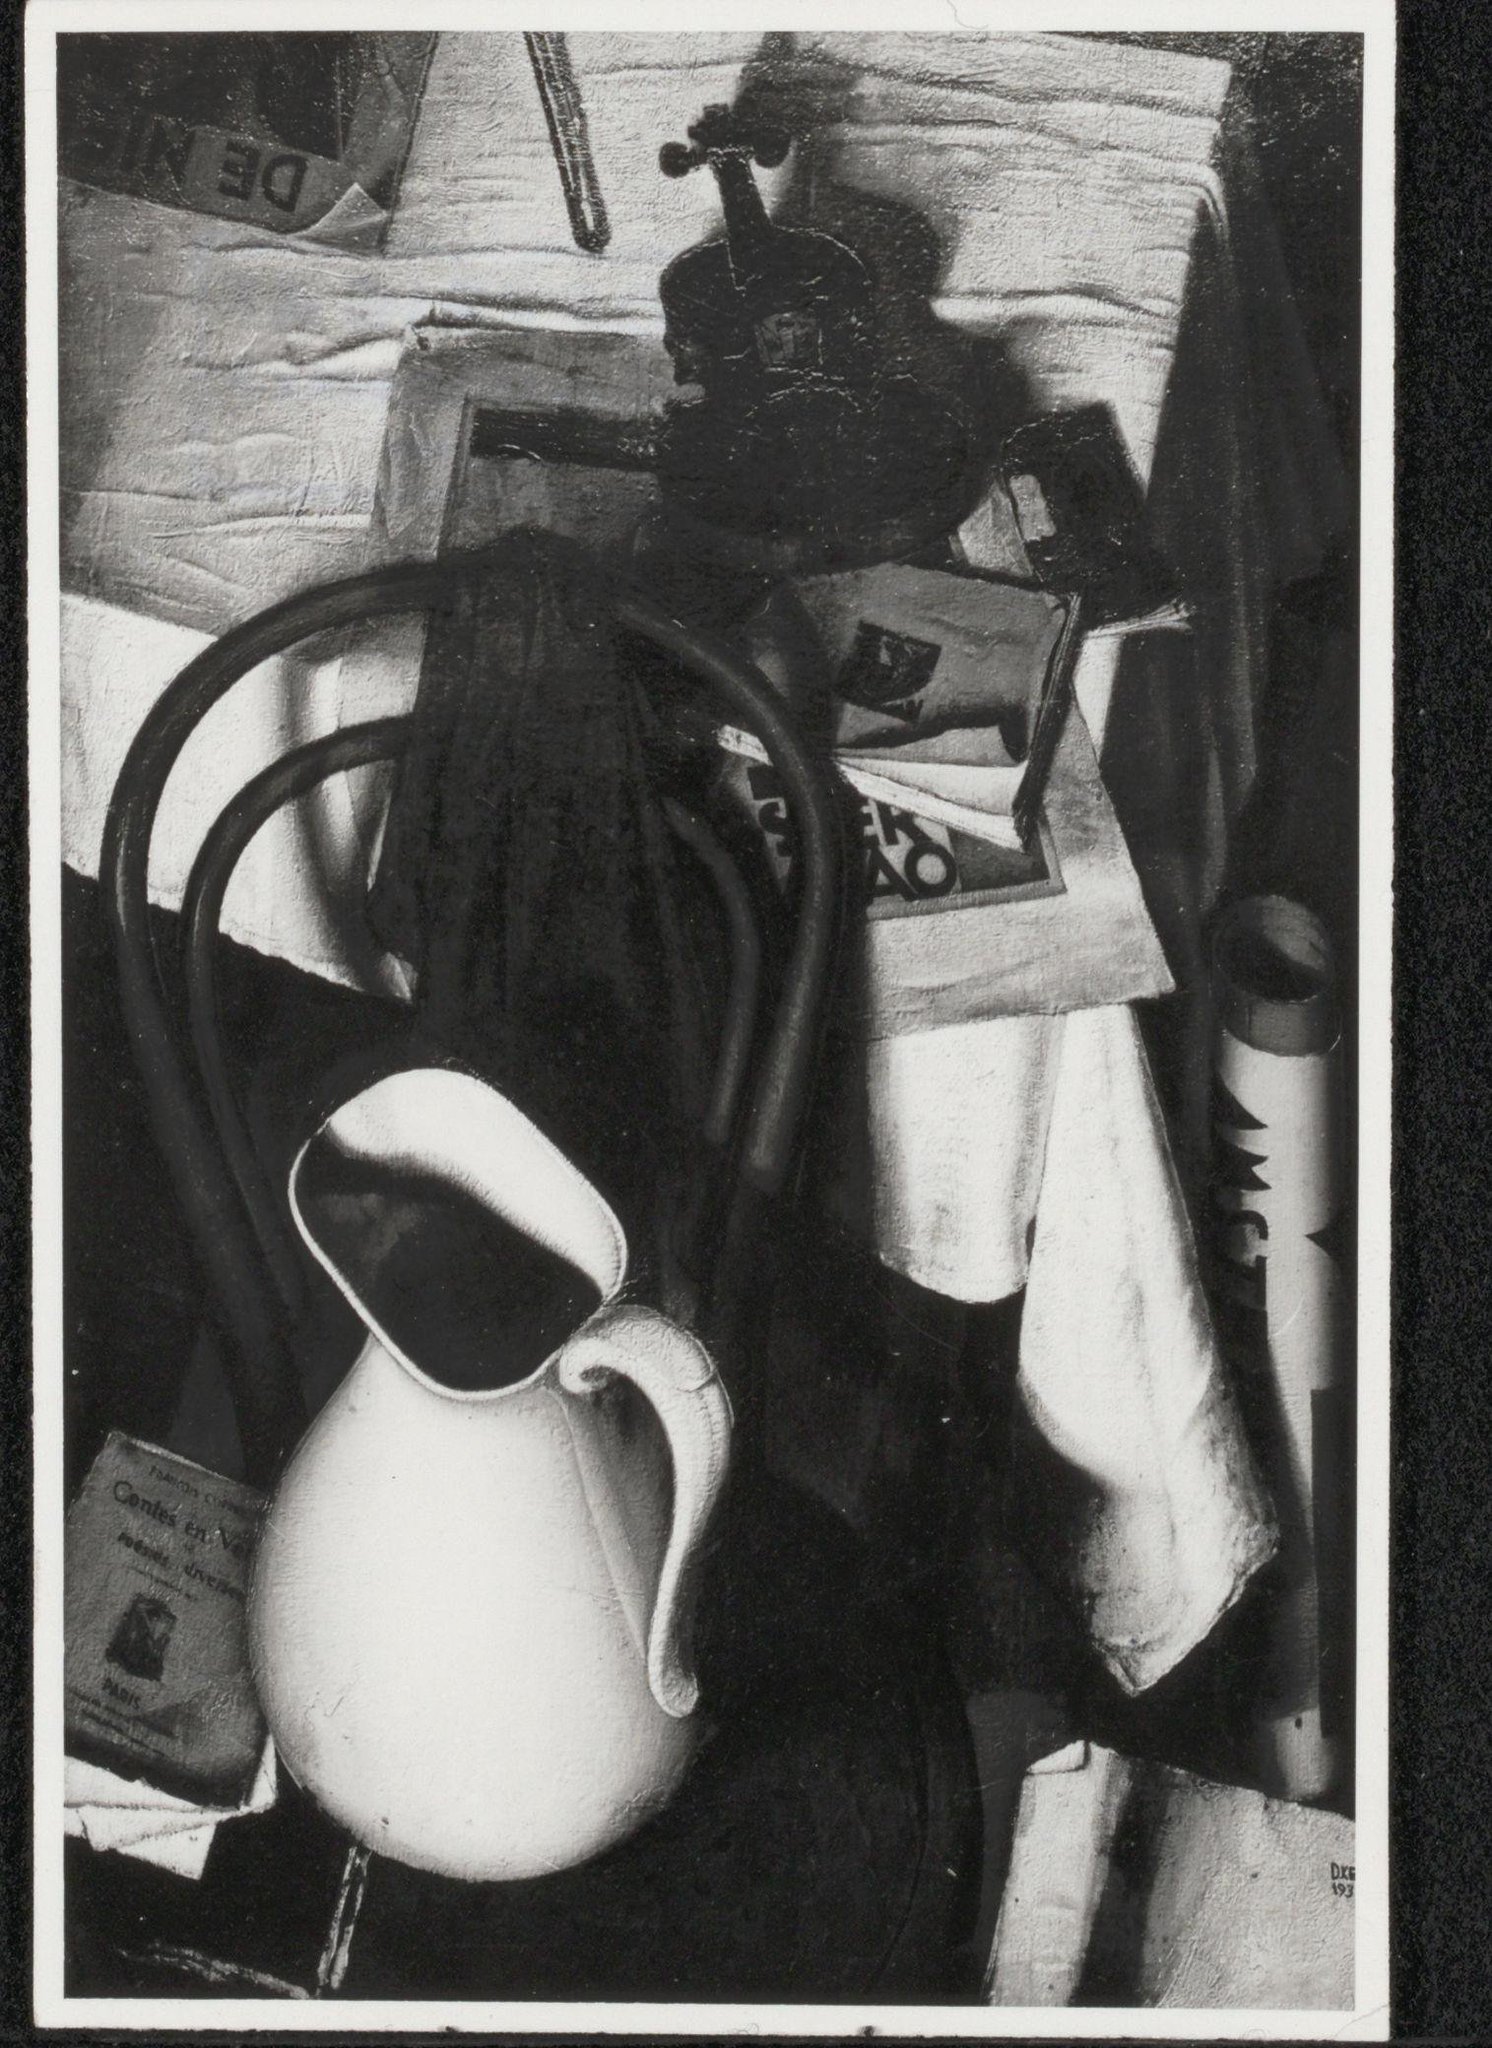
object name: photograph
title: Fotoreproductie van een geschilderd stilleven van Dick Ket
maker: Anonymous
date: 1931-2017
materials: photographic support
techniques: gelatin silver print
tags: den helder, print maker, draughtsman, dick ket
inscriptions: stamp: ‘COPYRIGHT/ Gemeentemuseum Arnhem’